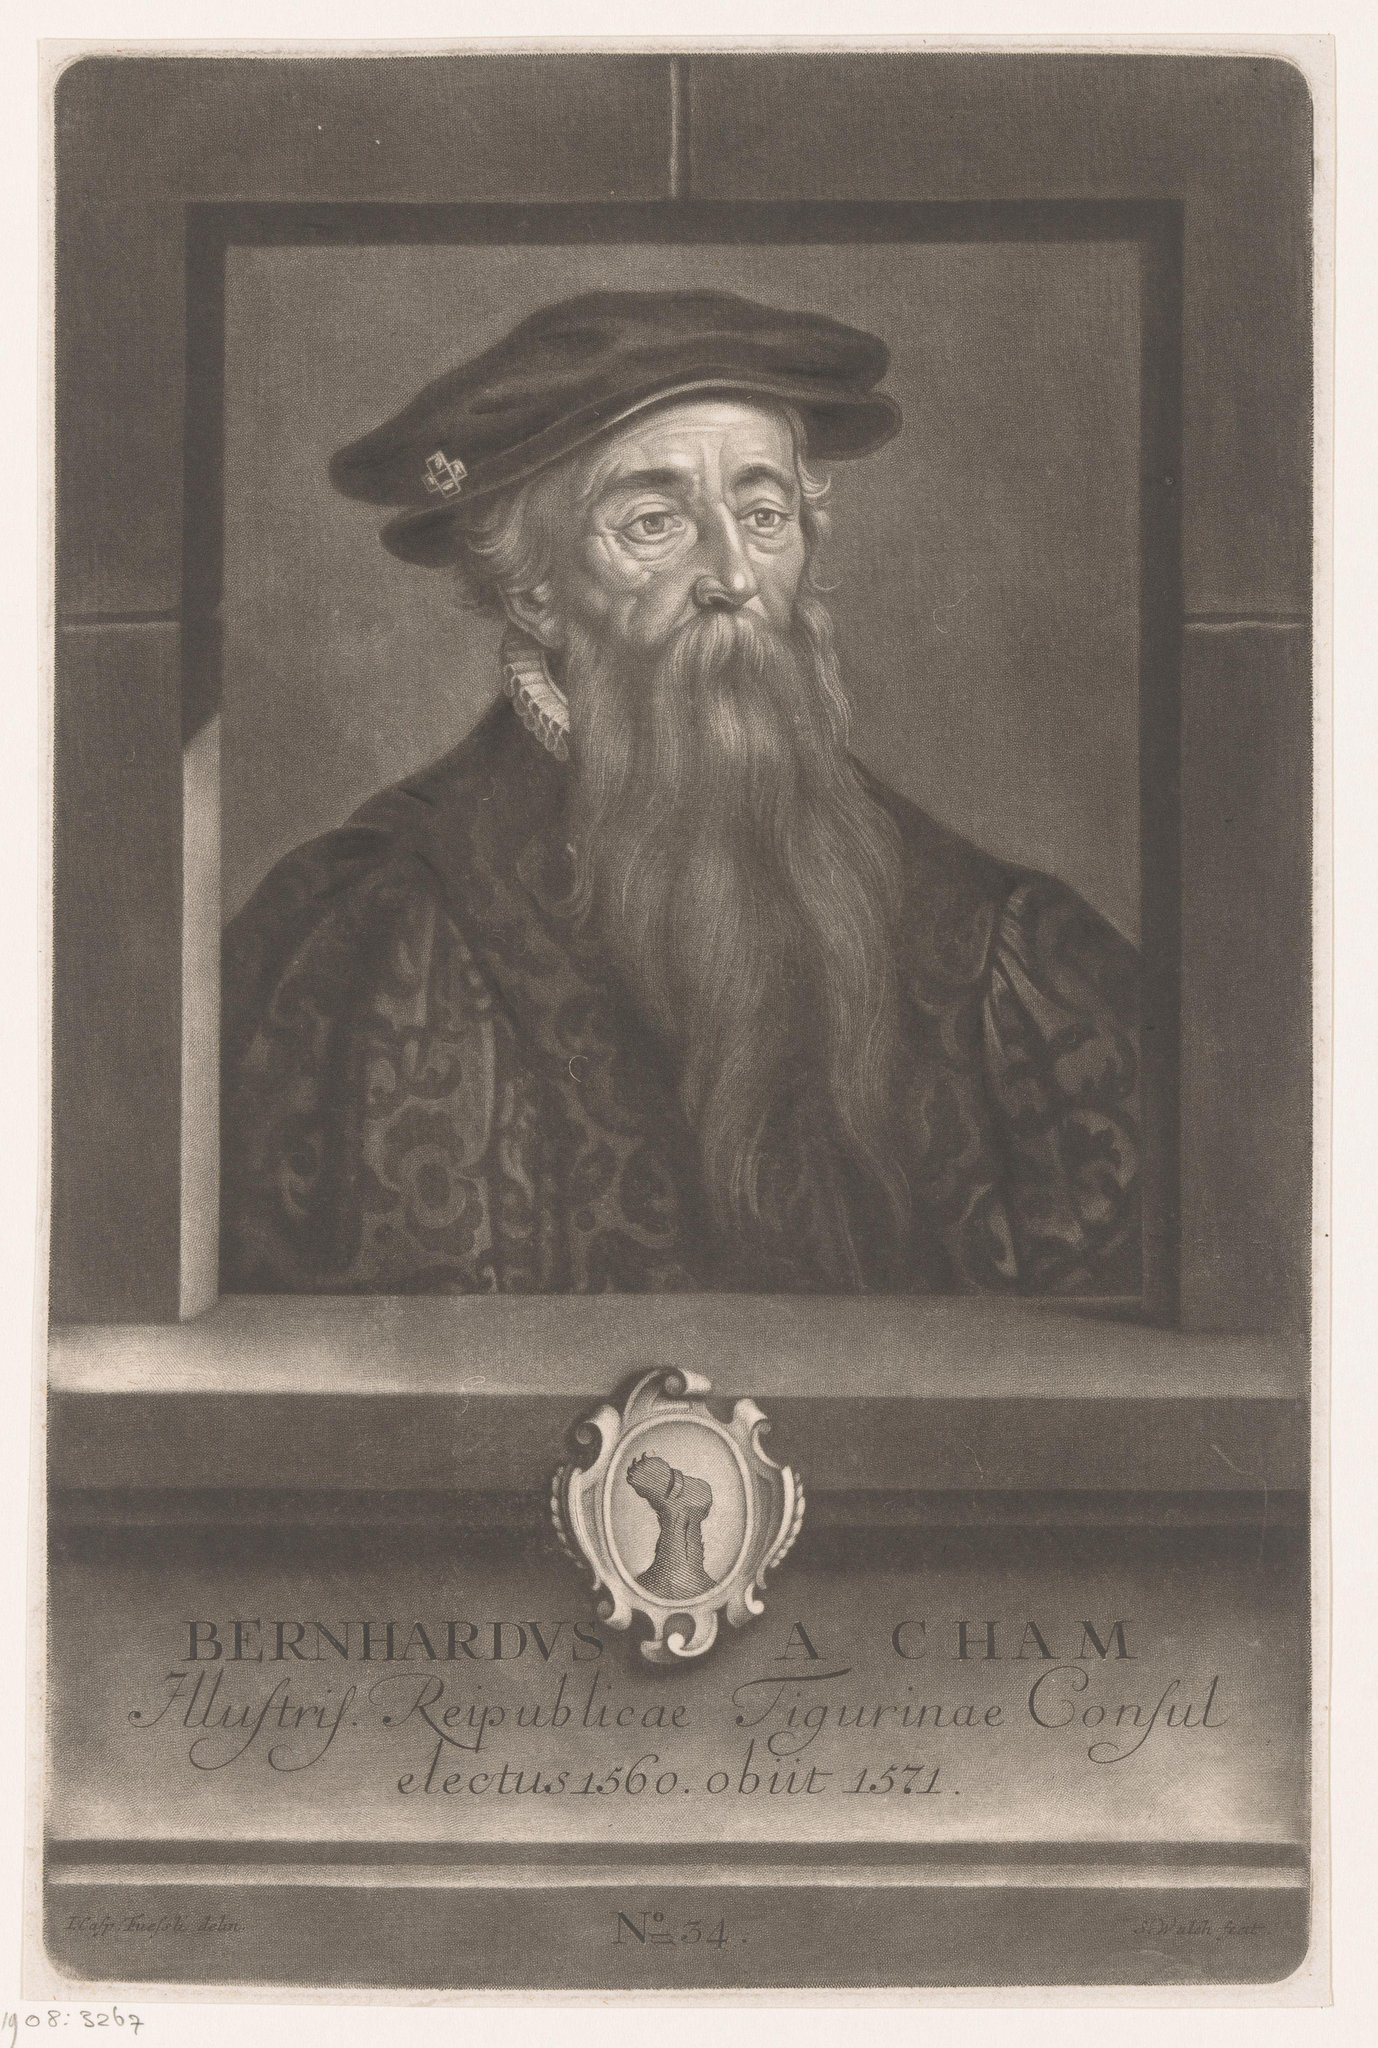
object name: print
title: Portret van Bernhard von Cham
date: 1731-1788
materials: paper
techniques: mezzotint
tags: mayor, historical persons, armorial bearing, heraldry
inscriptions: collector's mark: Lugt 2228